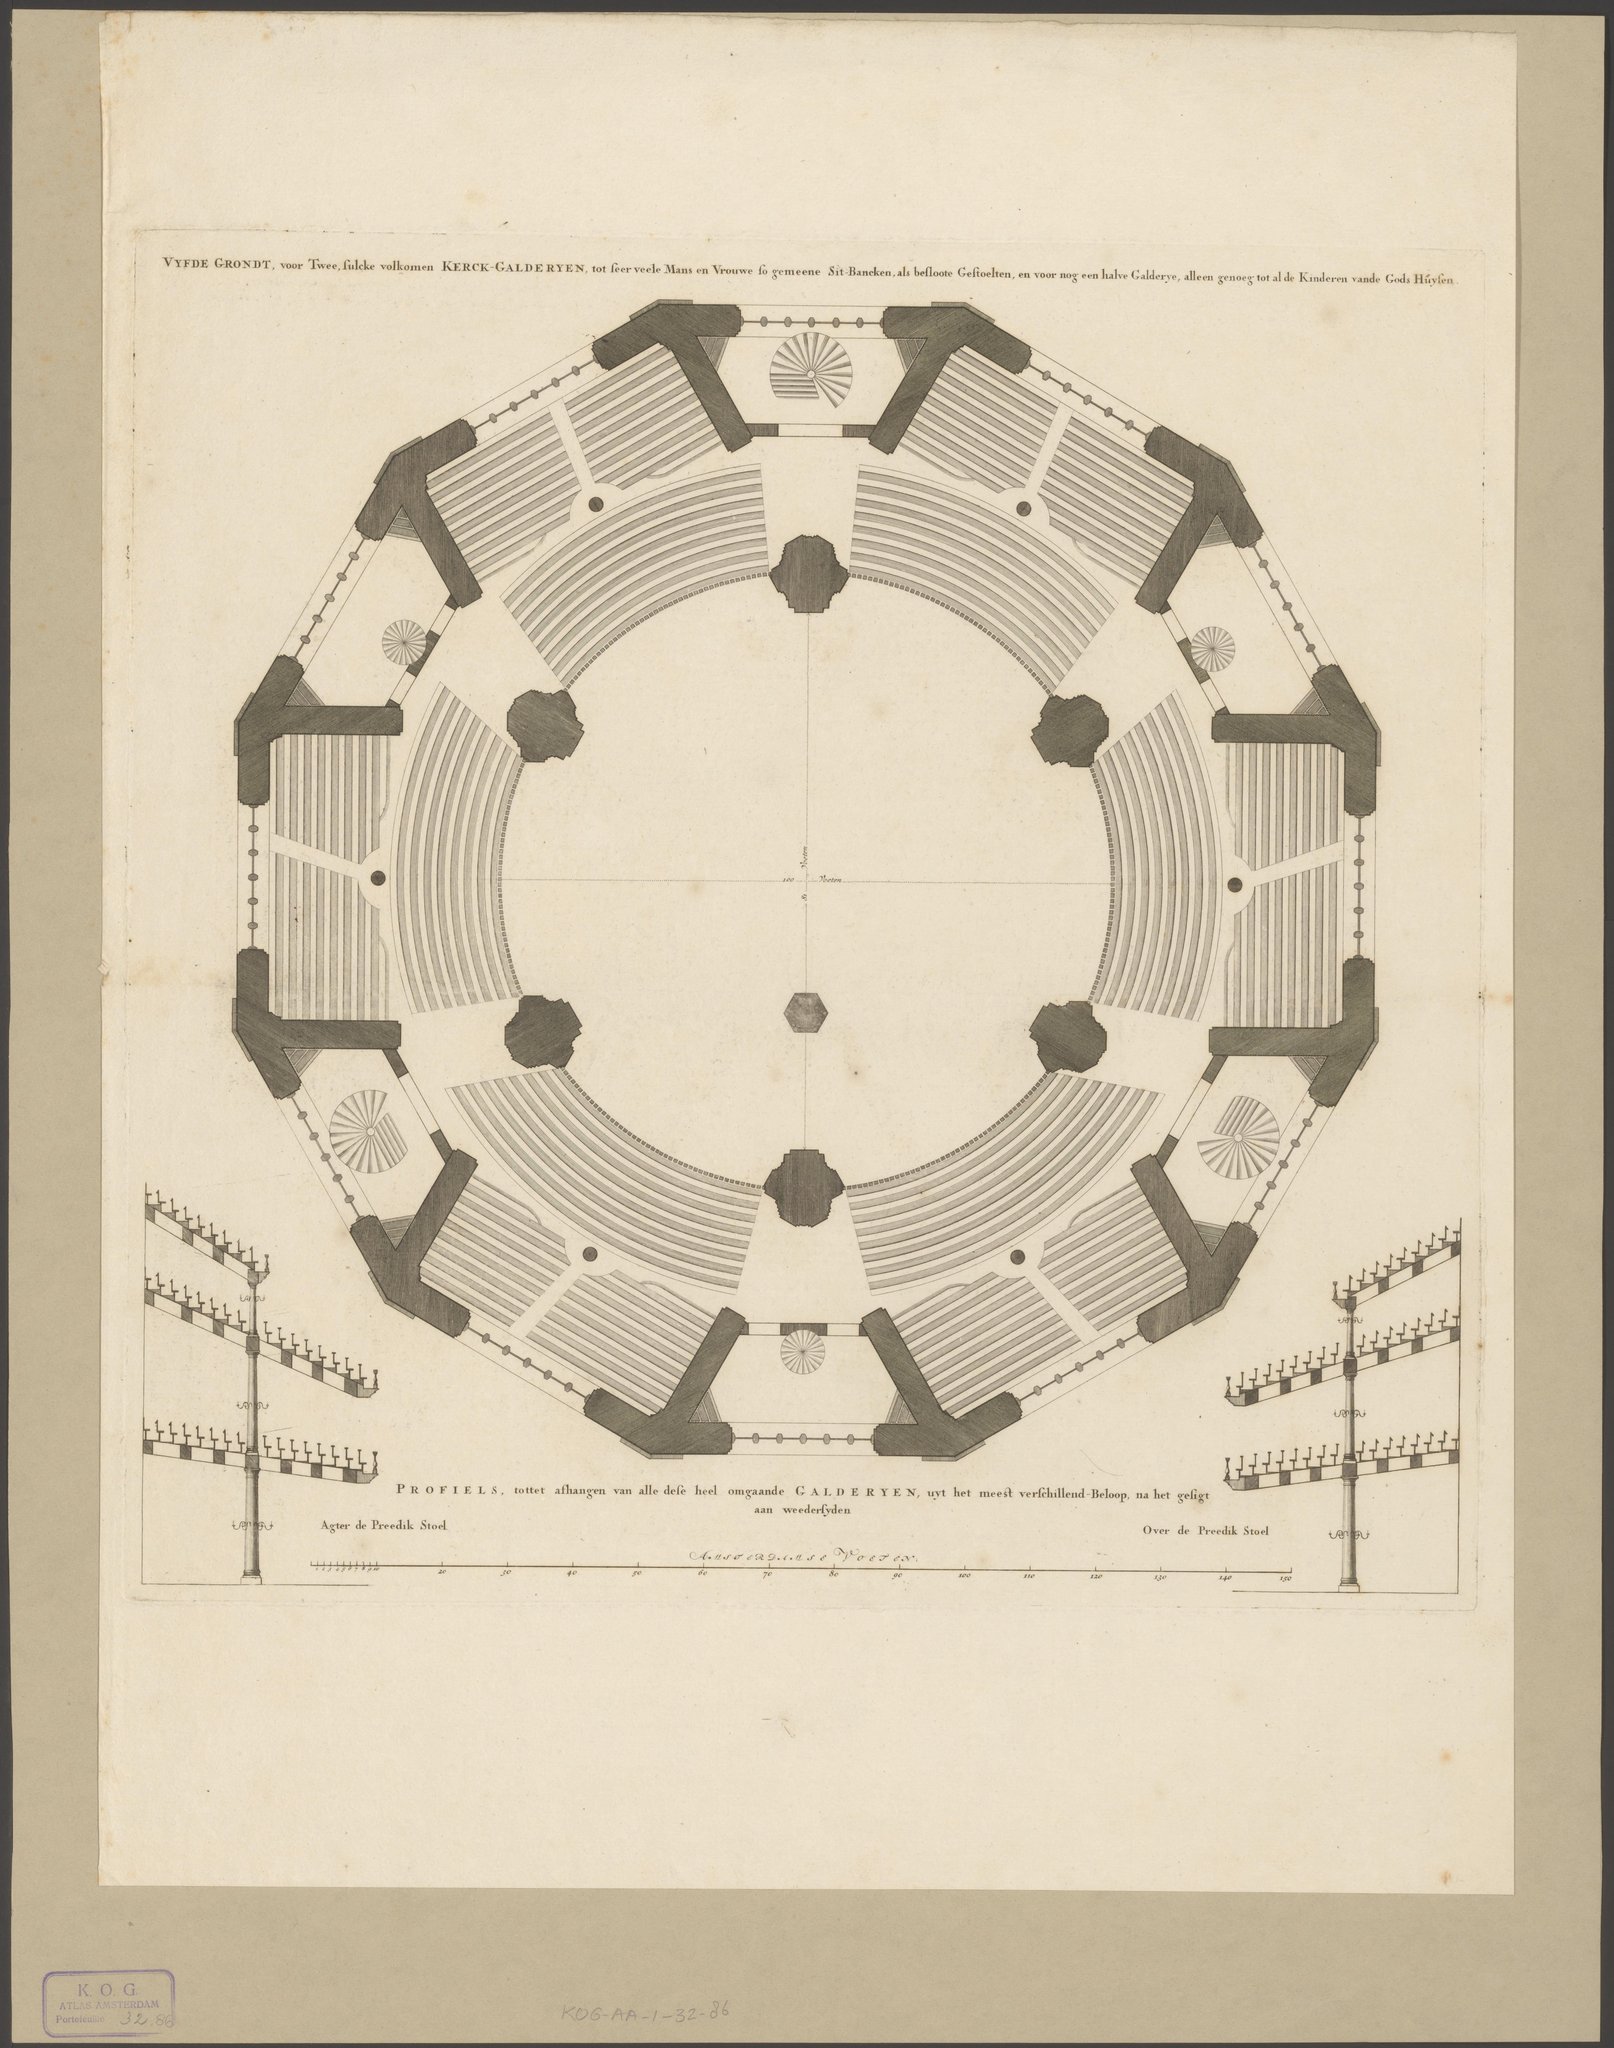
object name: print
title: Nievv desseyn tot een Seer Groote, Stercke, en om te hooren, heel bequame Coupel-Kerck (…)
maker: daniël stopendaal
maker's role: print maker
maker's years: 1672-1726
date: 1700-1705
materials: paper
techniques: engraving, etching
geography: amsterdam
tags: interior of church, plan ~ architecture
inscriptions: collector's mark: Lugt 1641b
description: Prent maakt mogelijk onderdeel uit van de serie: Nievv desseyn tot een Seer Groote, Stercke, en om te hooren, heel bequame Coupel-Kerck (…). Deze serie van zeventien prenten werd rond 1700 in opdracht van en naar ontwerp van notaris Nicolaas Listingh gemaakt, mogelijk door Daniël Stoopendaal. Zie daarover: Long, Isaac le. Historische beschryvinge van de reformatie der stadt Amsterdam (…). Amsterdam: Johannes van Septeren (I), 1729, p. 572.